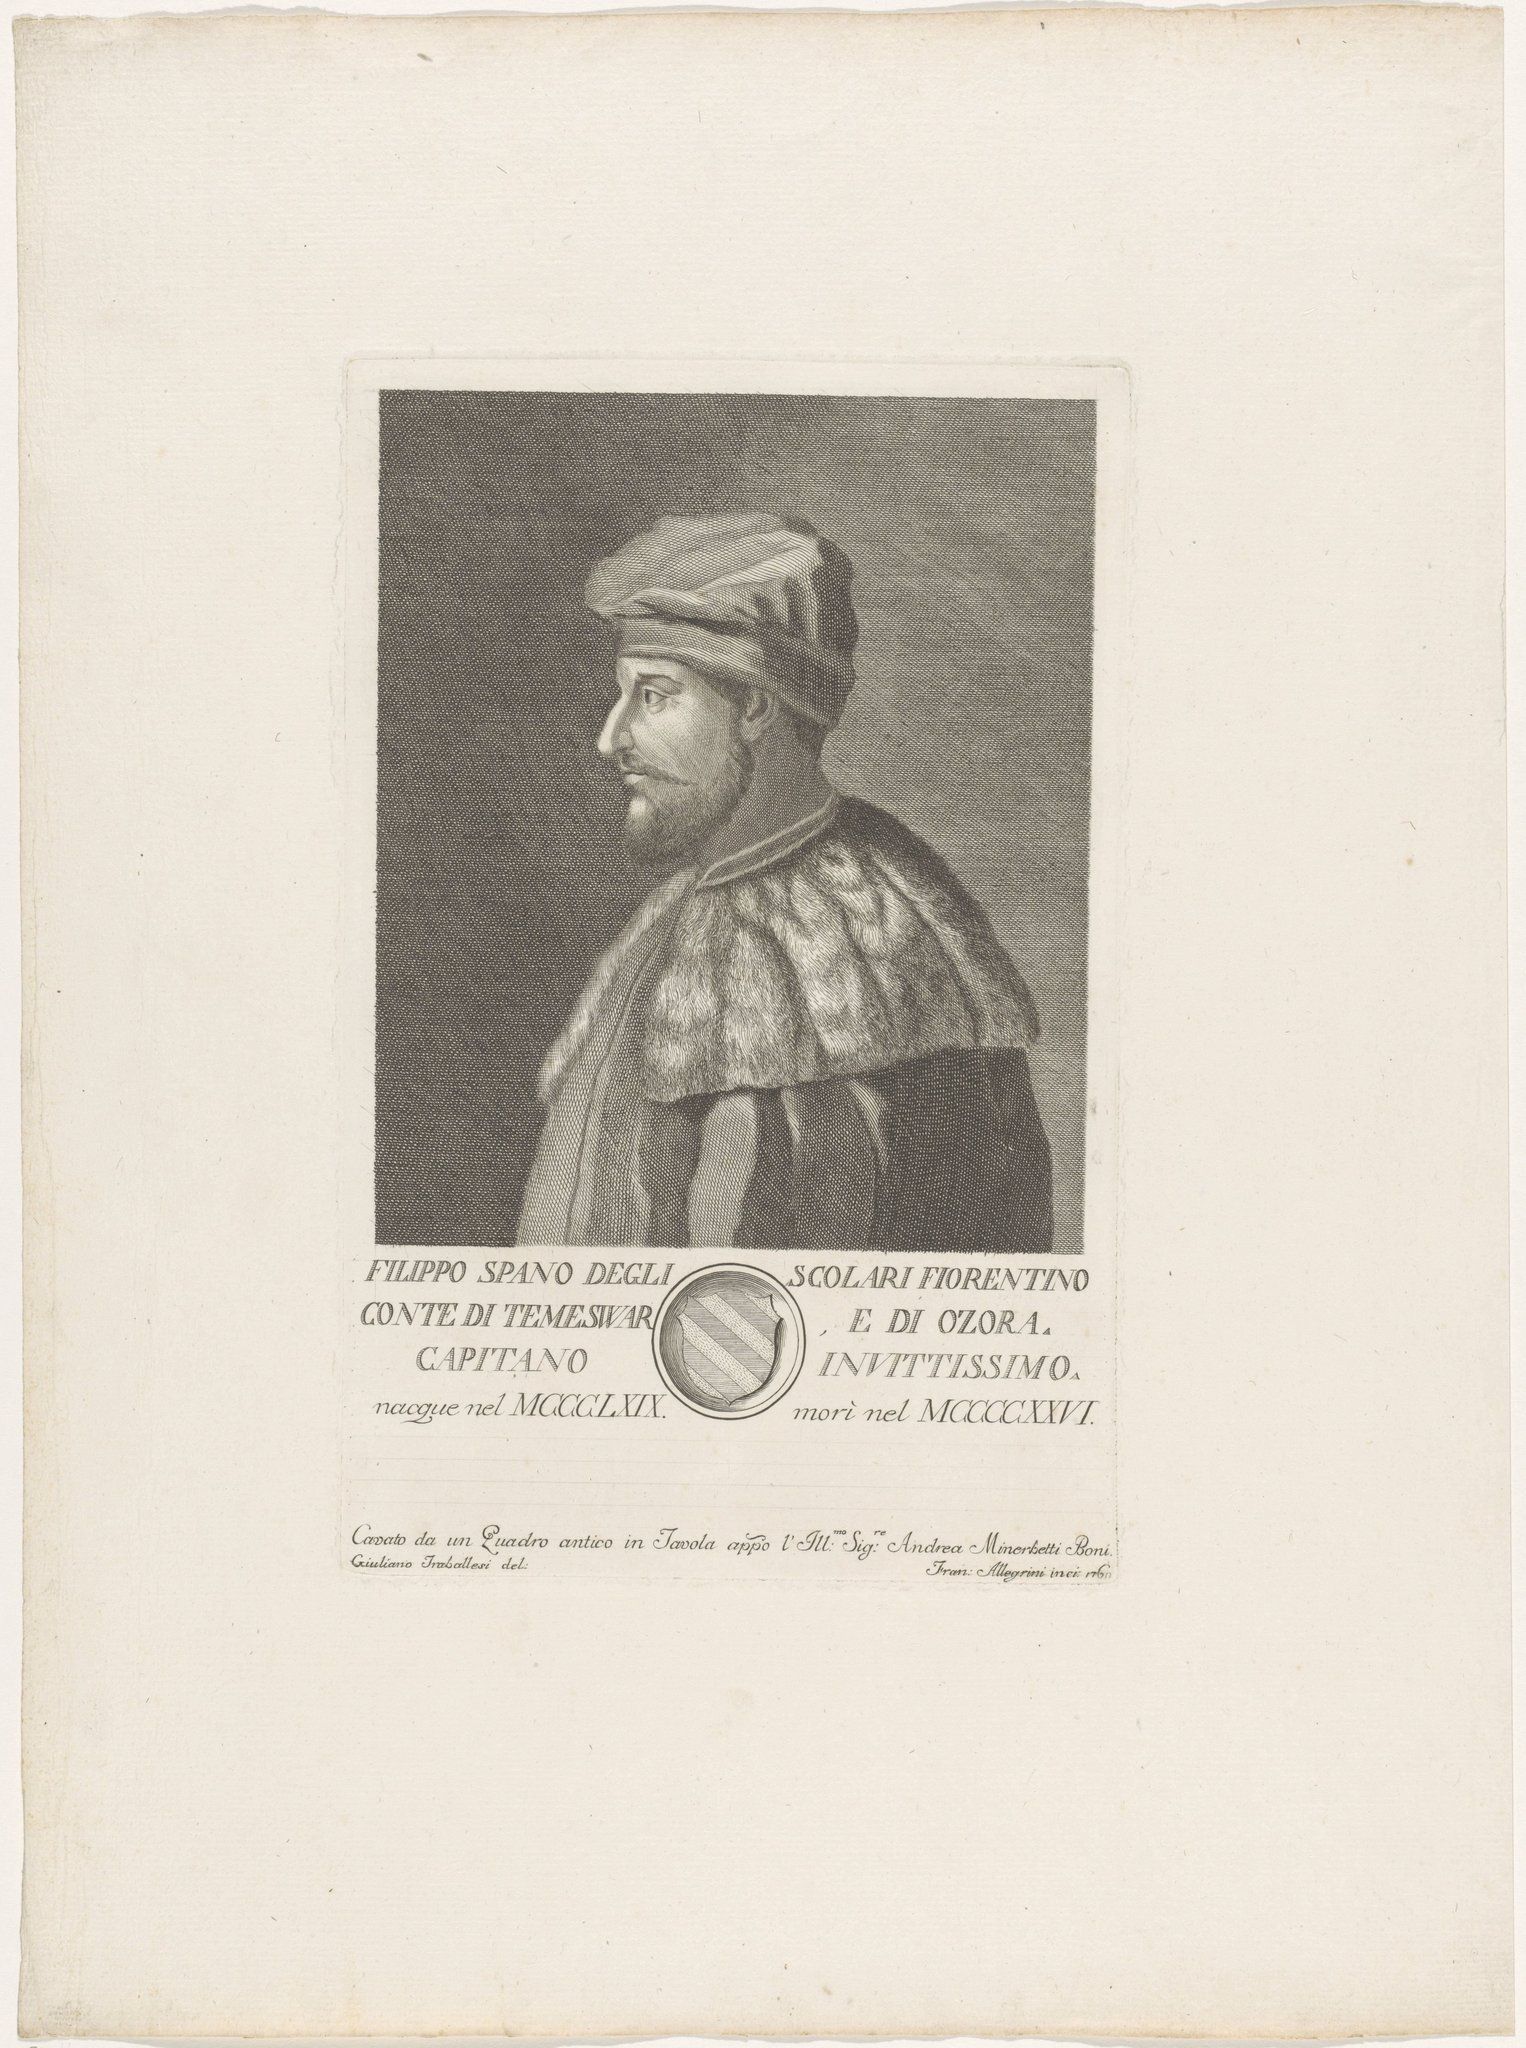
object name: print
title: Portret van Filippo Buondelmonti degli Scolari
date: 1762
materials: paper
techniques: engraving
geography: italy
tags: historical persons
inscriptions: collector's mark: Lugt 2228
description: Deze prent maakt deel uit van een reeks portretprenten van onbekende omvang. De prenten zijn gemaakt door meedere prentmakers, onder wie Francesco Allegrini en Carlo en Raimondo Faucci.